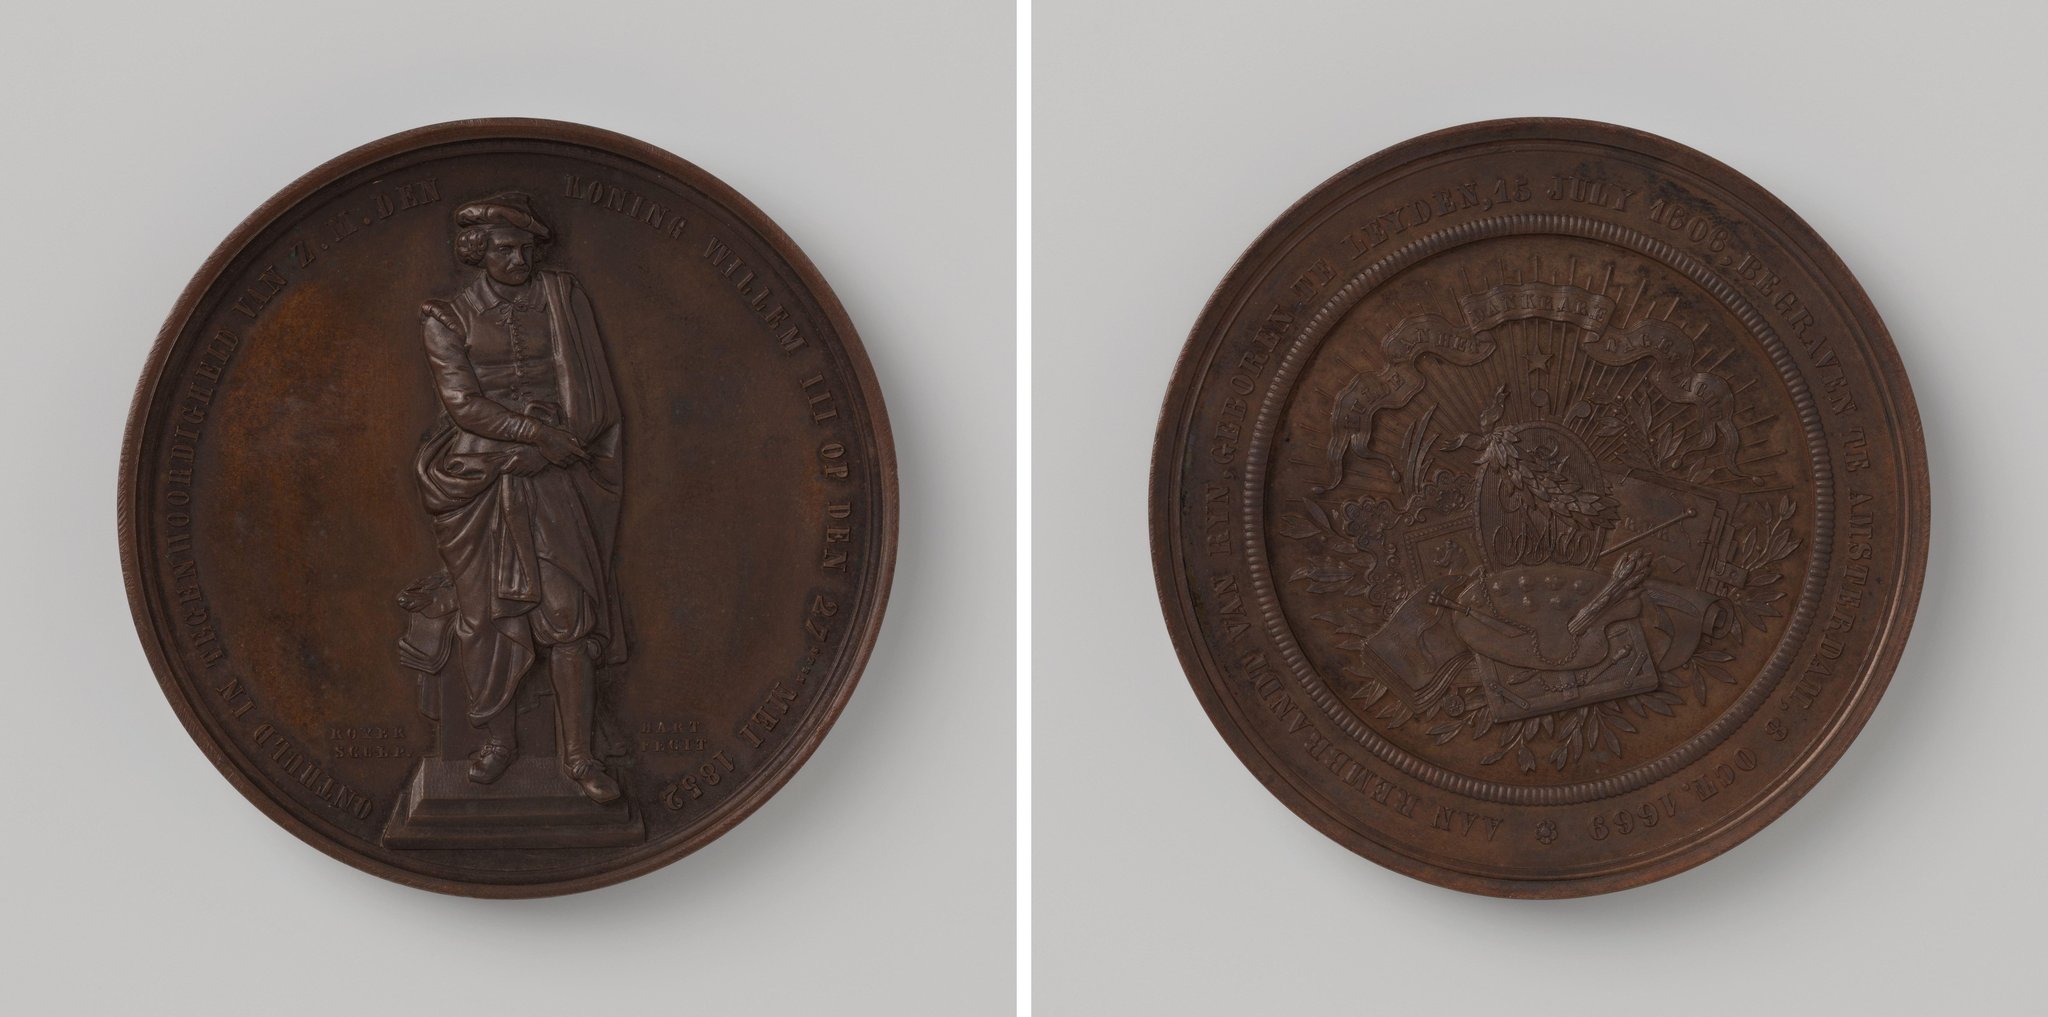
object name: history medal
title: Onthulling van het standbeeld van Rembrandt van Rijn te Amsterdam 1852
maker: hart (stempelsnijder)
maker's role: die cutter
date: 1852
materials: bronze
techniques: striking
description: Bronzen penning, op de voorzjde het standbeeld, gezien van voren, met omschrift, op de keerzijde een stralend omkranst ovalen medaillon beschreven RVR te midden van diverse schildersattributen, bovenaan een tekstlint en onderaan olijftakken, alles binnen een verheven rand waarin het omschrift.